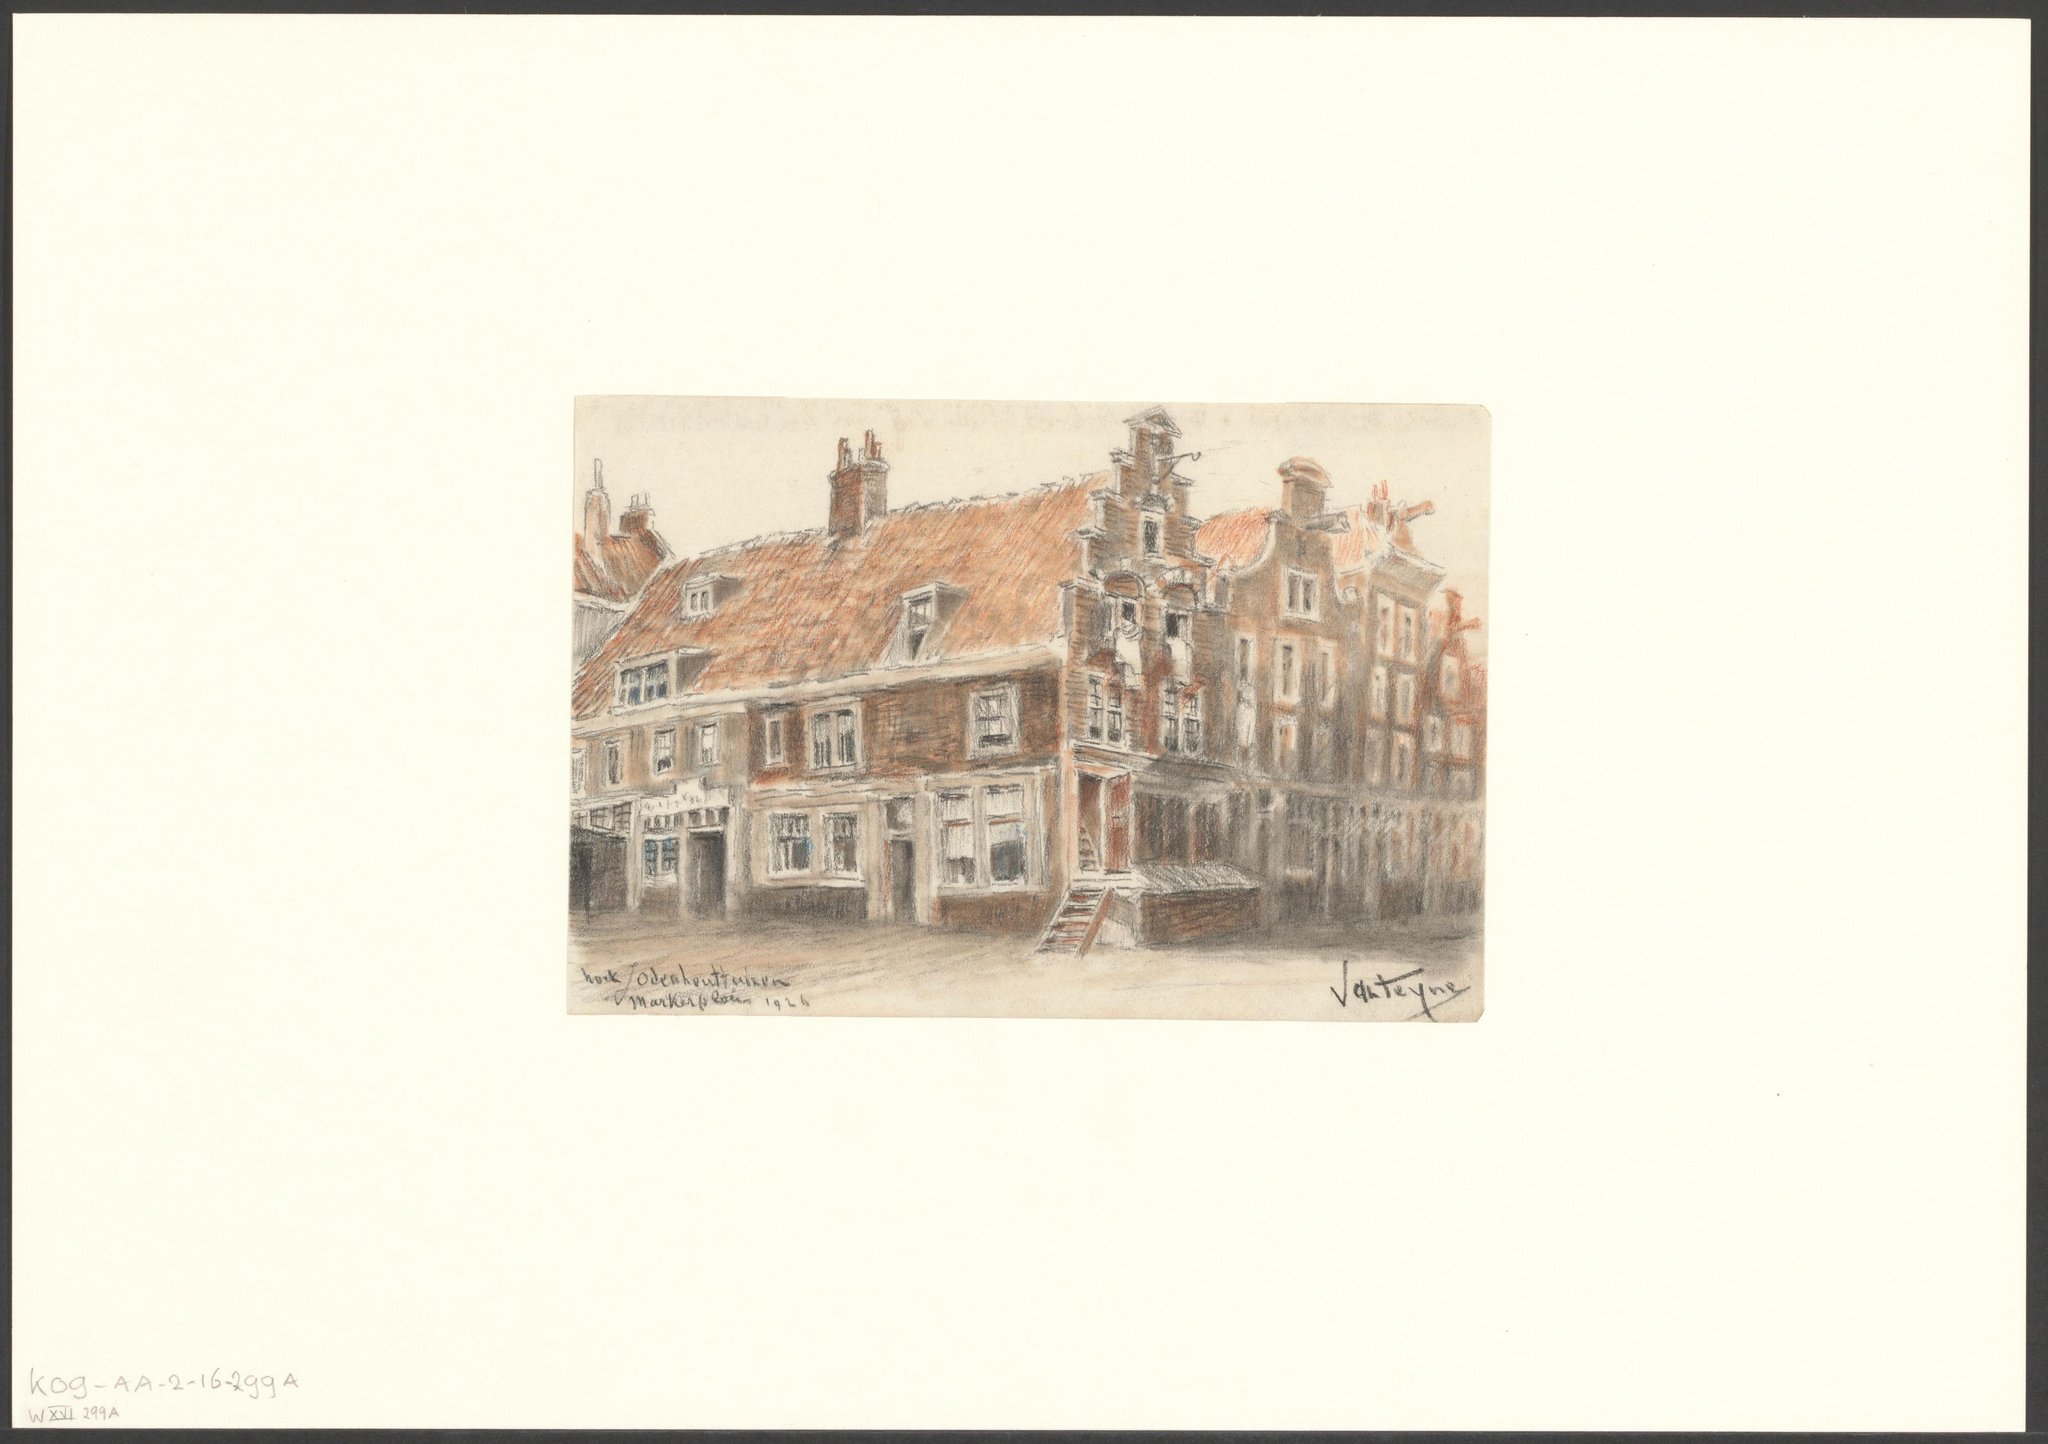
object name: drawing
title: Gezicht op de Joden Houttuinen, hoek Markenplein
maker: anthonie van teijn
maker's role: draughtsman, painter, print maker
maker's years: 1863-1943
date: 1926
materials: chalk, paper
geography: amsterdam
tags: city-view in general; 'veduta', façade (of house or building), street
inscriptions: inscription: ‘hoek Jodenhouttuinen / markenplein 1926’, signature: ‘VanTeyne’, stamp: ‘J. van Eck.’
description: Tekening binnen de Atlas Van Eck ingedeeld op wijknummer 16.